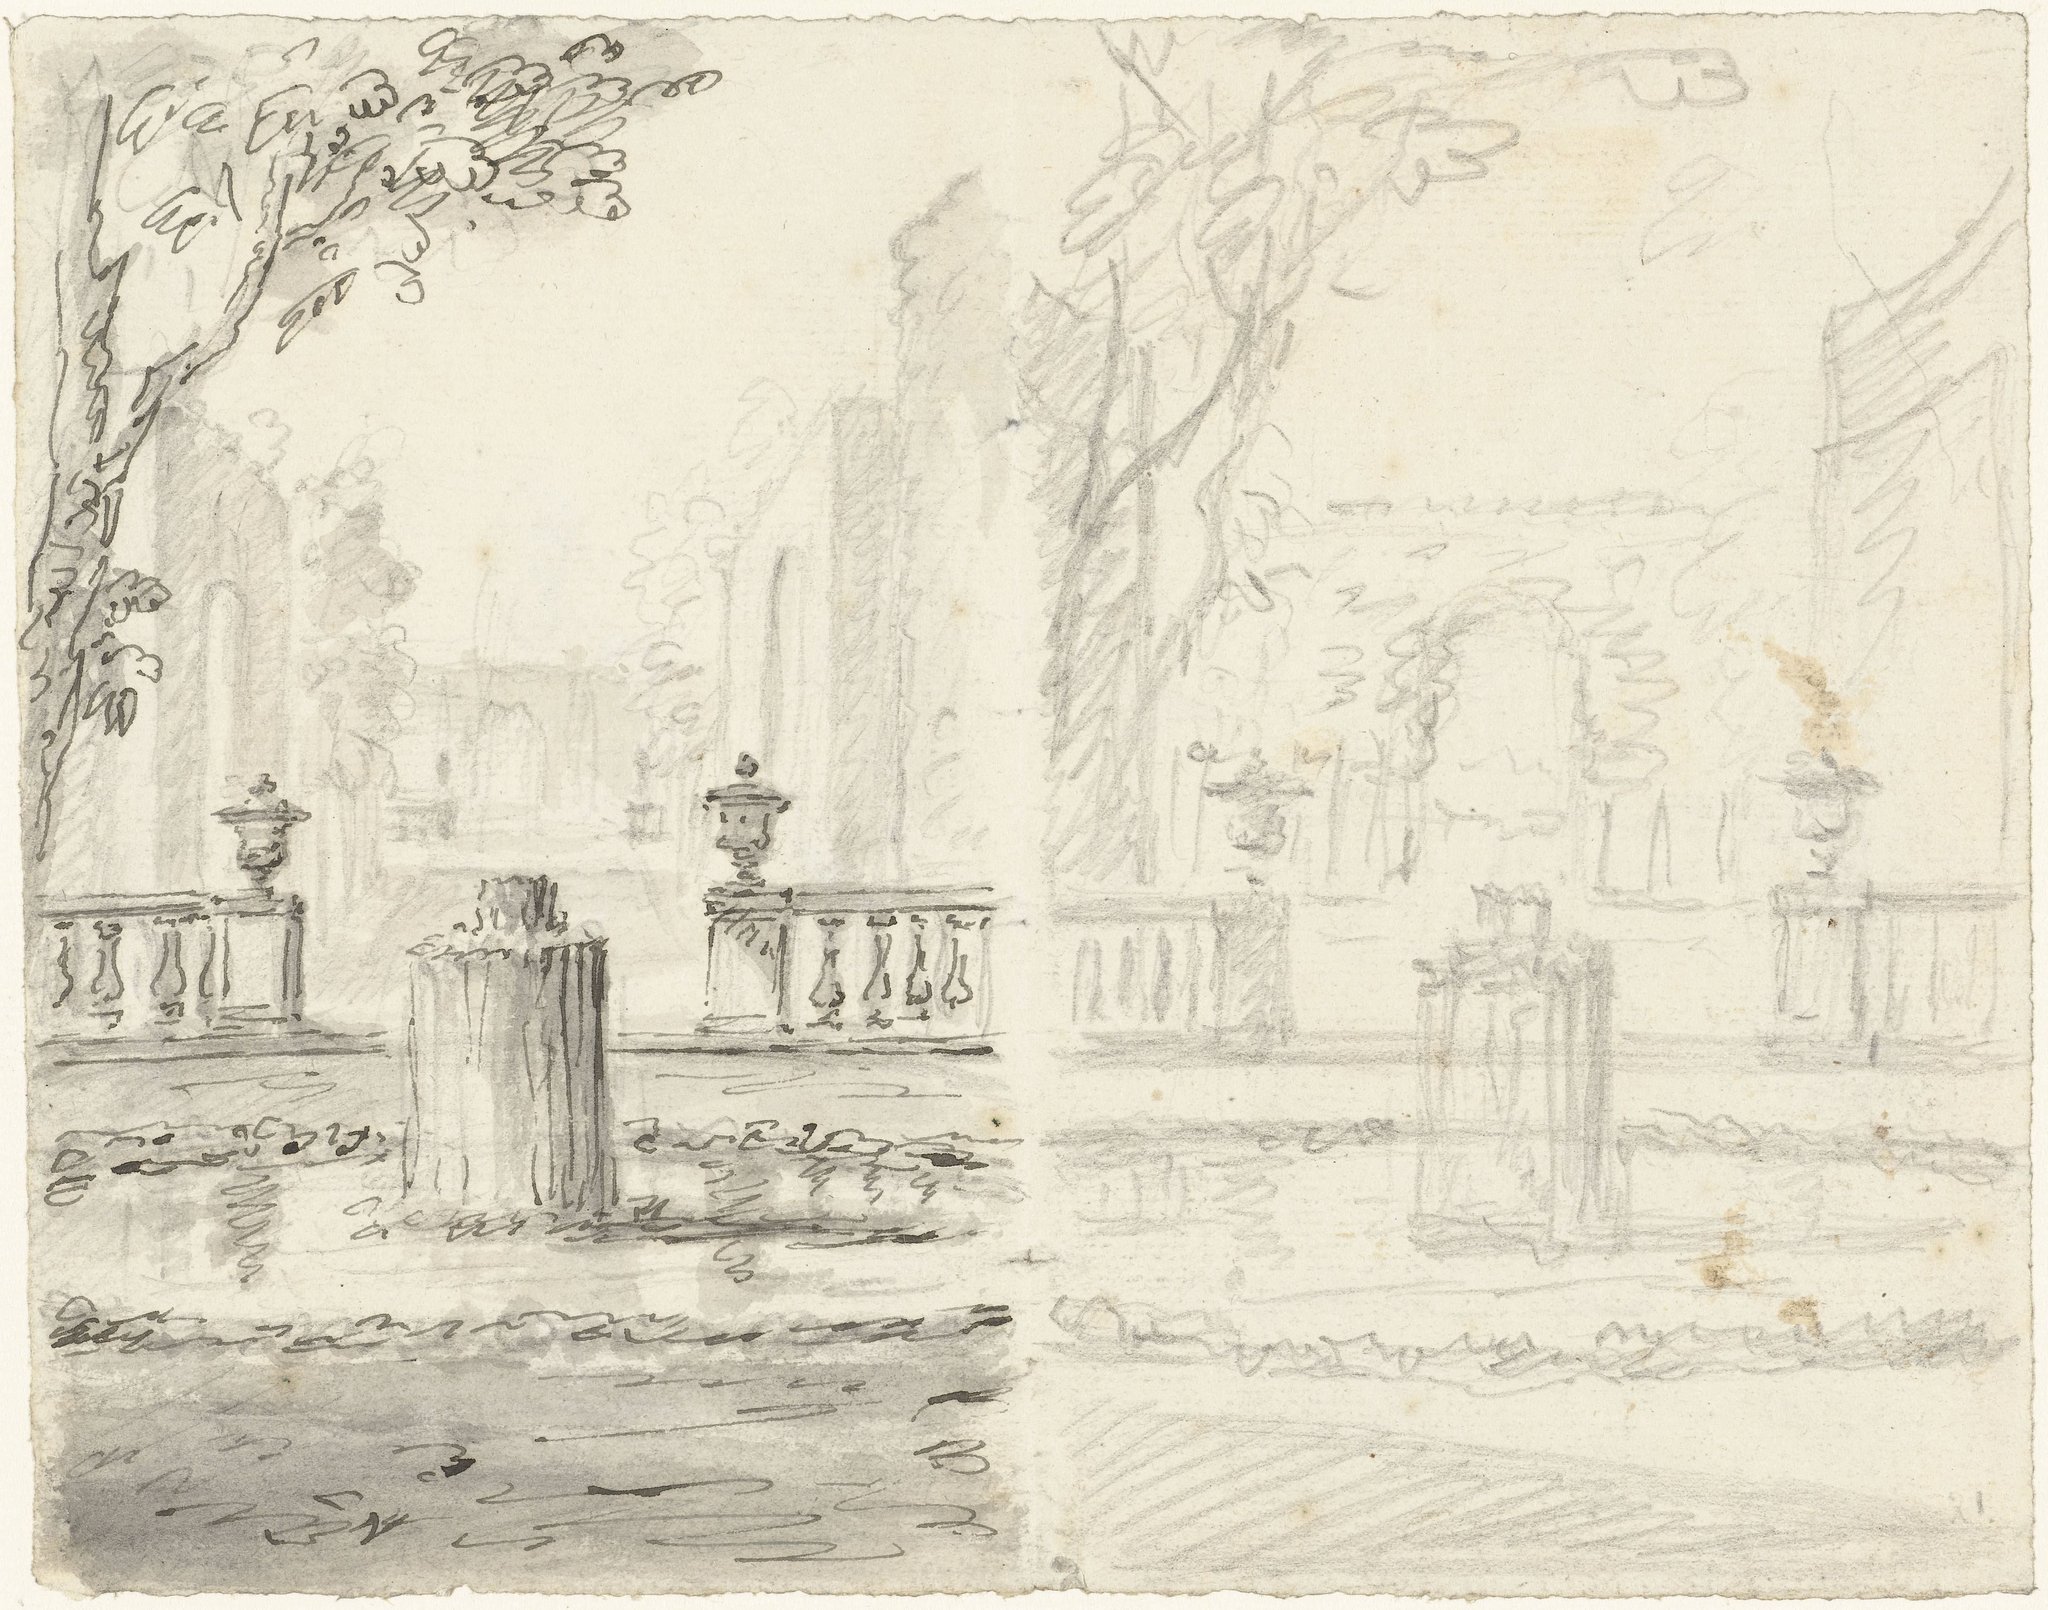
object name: design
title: Twee ontwerpen voor een tuingezicht en een balustrade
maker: dionys van nijmegen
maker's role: draughtsman, painter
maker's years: 1705-1798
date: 1715-1798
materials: ink, paper, pencil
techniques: pen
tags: garden, garden fountain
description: Twee ontwerpen voor een tuingezicht met fontein en een balustrade met twee tuinvazen. Ontwerp voor een schildering.